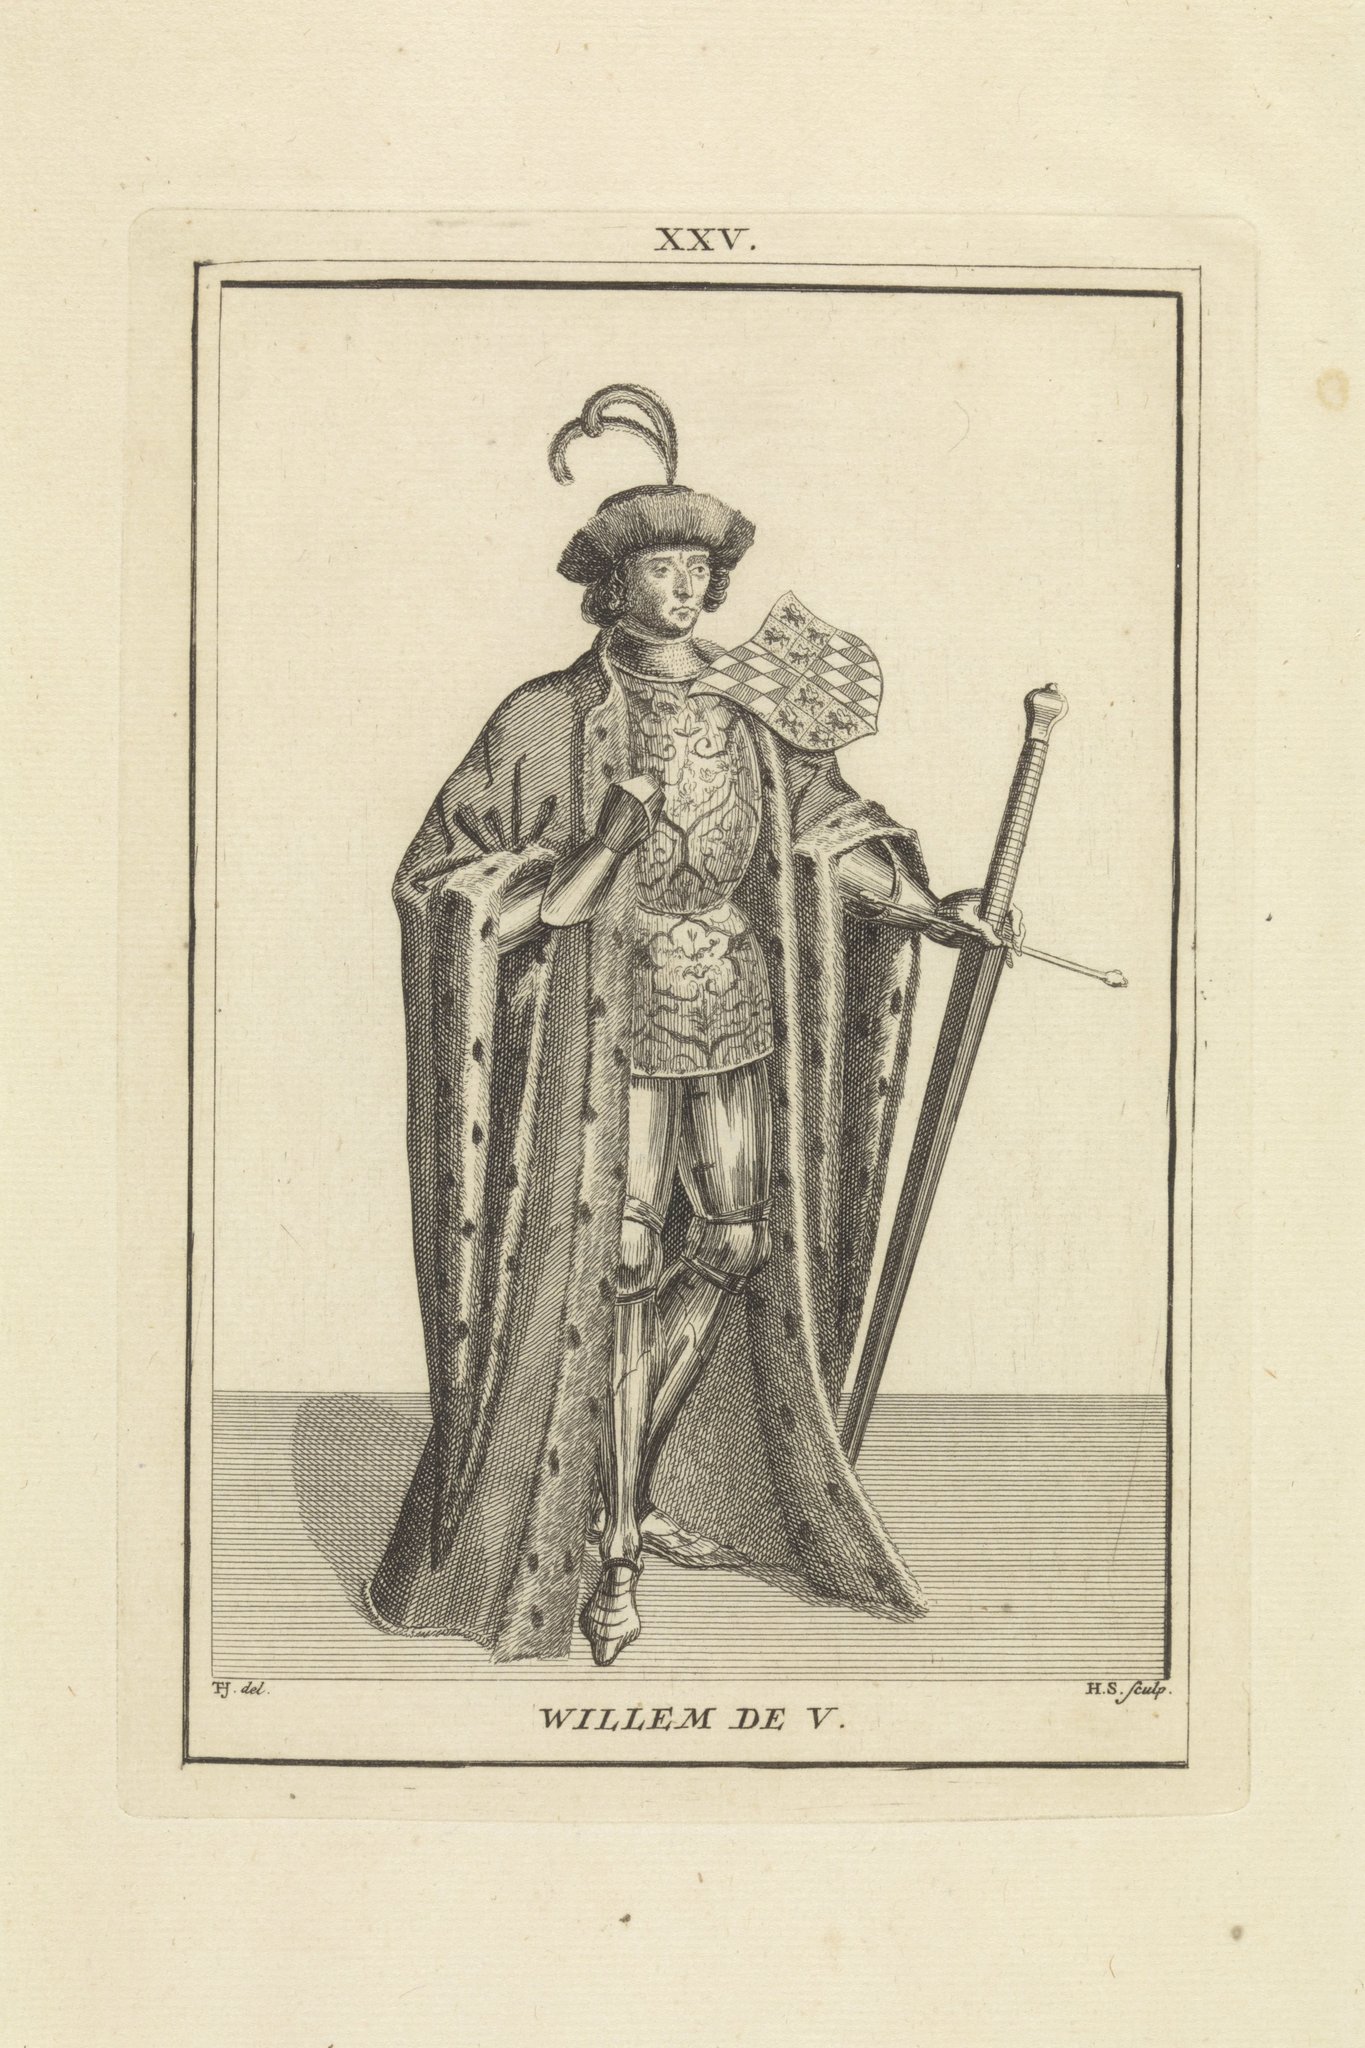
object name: print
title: Portret van Willem V, graaf van Holland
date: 1745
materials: paper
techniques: etching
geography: haarlem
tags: earl, willem v van holland (graaf van holland en zeeland), nobility and patriciate; chivalry, knighthood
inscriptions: collector's mark: Lugt 2228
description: Boekillustratie voor: Langendyk, Pieter. De Graaven van Holland, in jaardichten beschreven door Pieter Langendyk. Verykt met alle de beeldtenissen dier prinsen, naauwkeurig getekend naar de echte aloude tafereelen of de zaal van't raadhuis der stad Haarlem. Haarlem: J. Bosch, 1745.